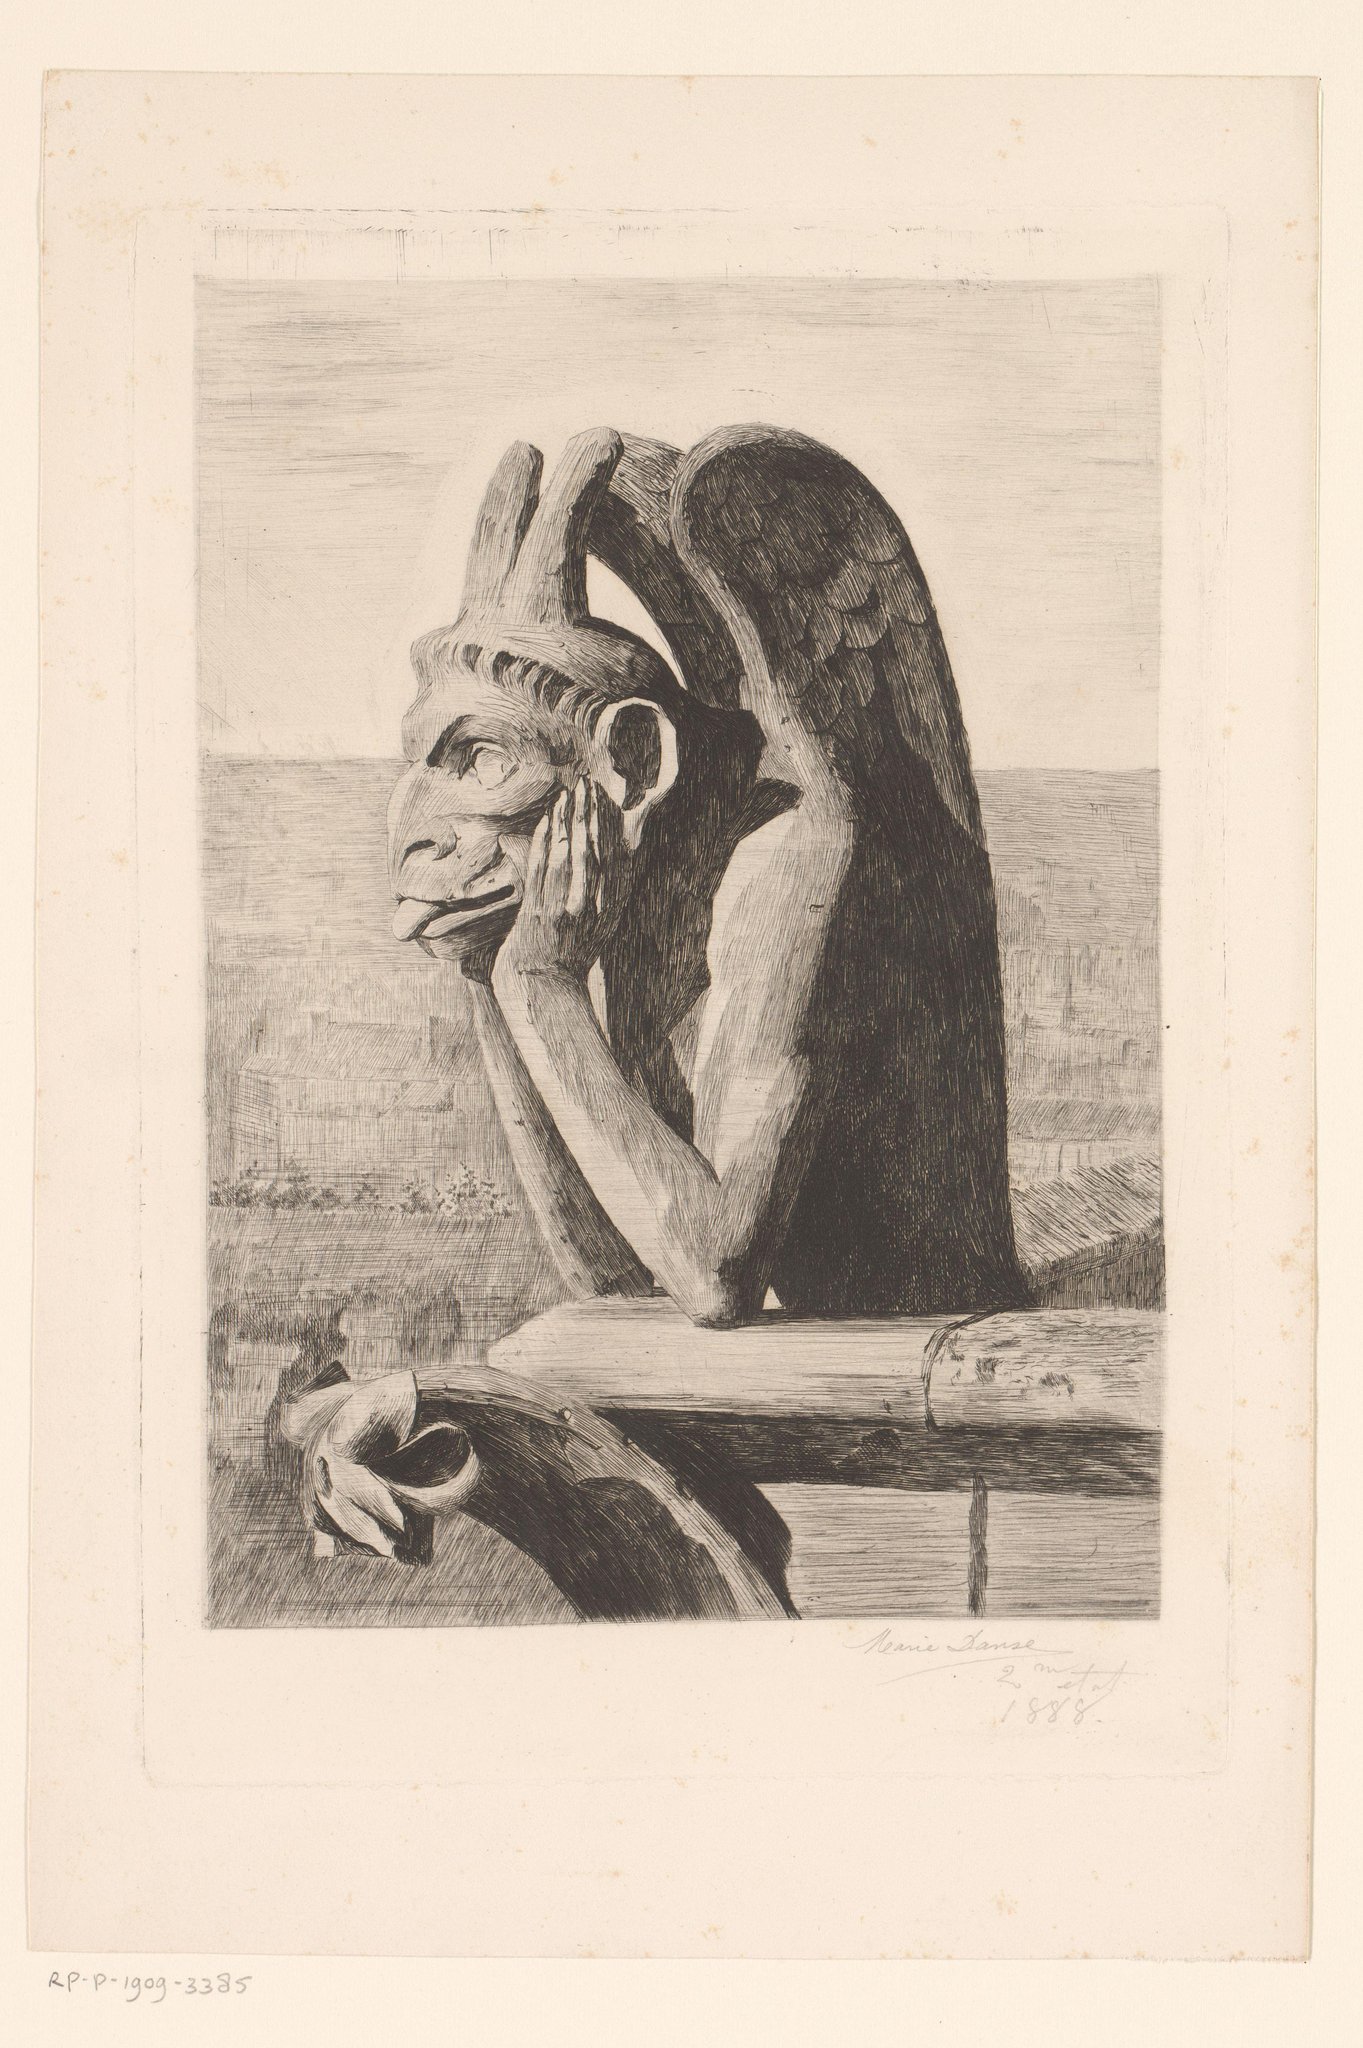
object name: print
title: Waterspuwer van de Notre-Dame te Parijs met vleugels en uitstekende tong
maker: marie danse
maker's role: print maker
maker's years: 1867-1942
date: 1888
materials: paper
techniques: etching, intaglio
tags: ornament ~ hybrid animals, piece of sculpture, reproduction of a piece of sculpture, parts of church exterior and annexes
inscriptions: inscription: ‘2m etat’, collector's mark: Lugt 2228